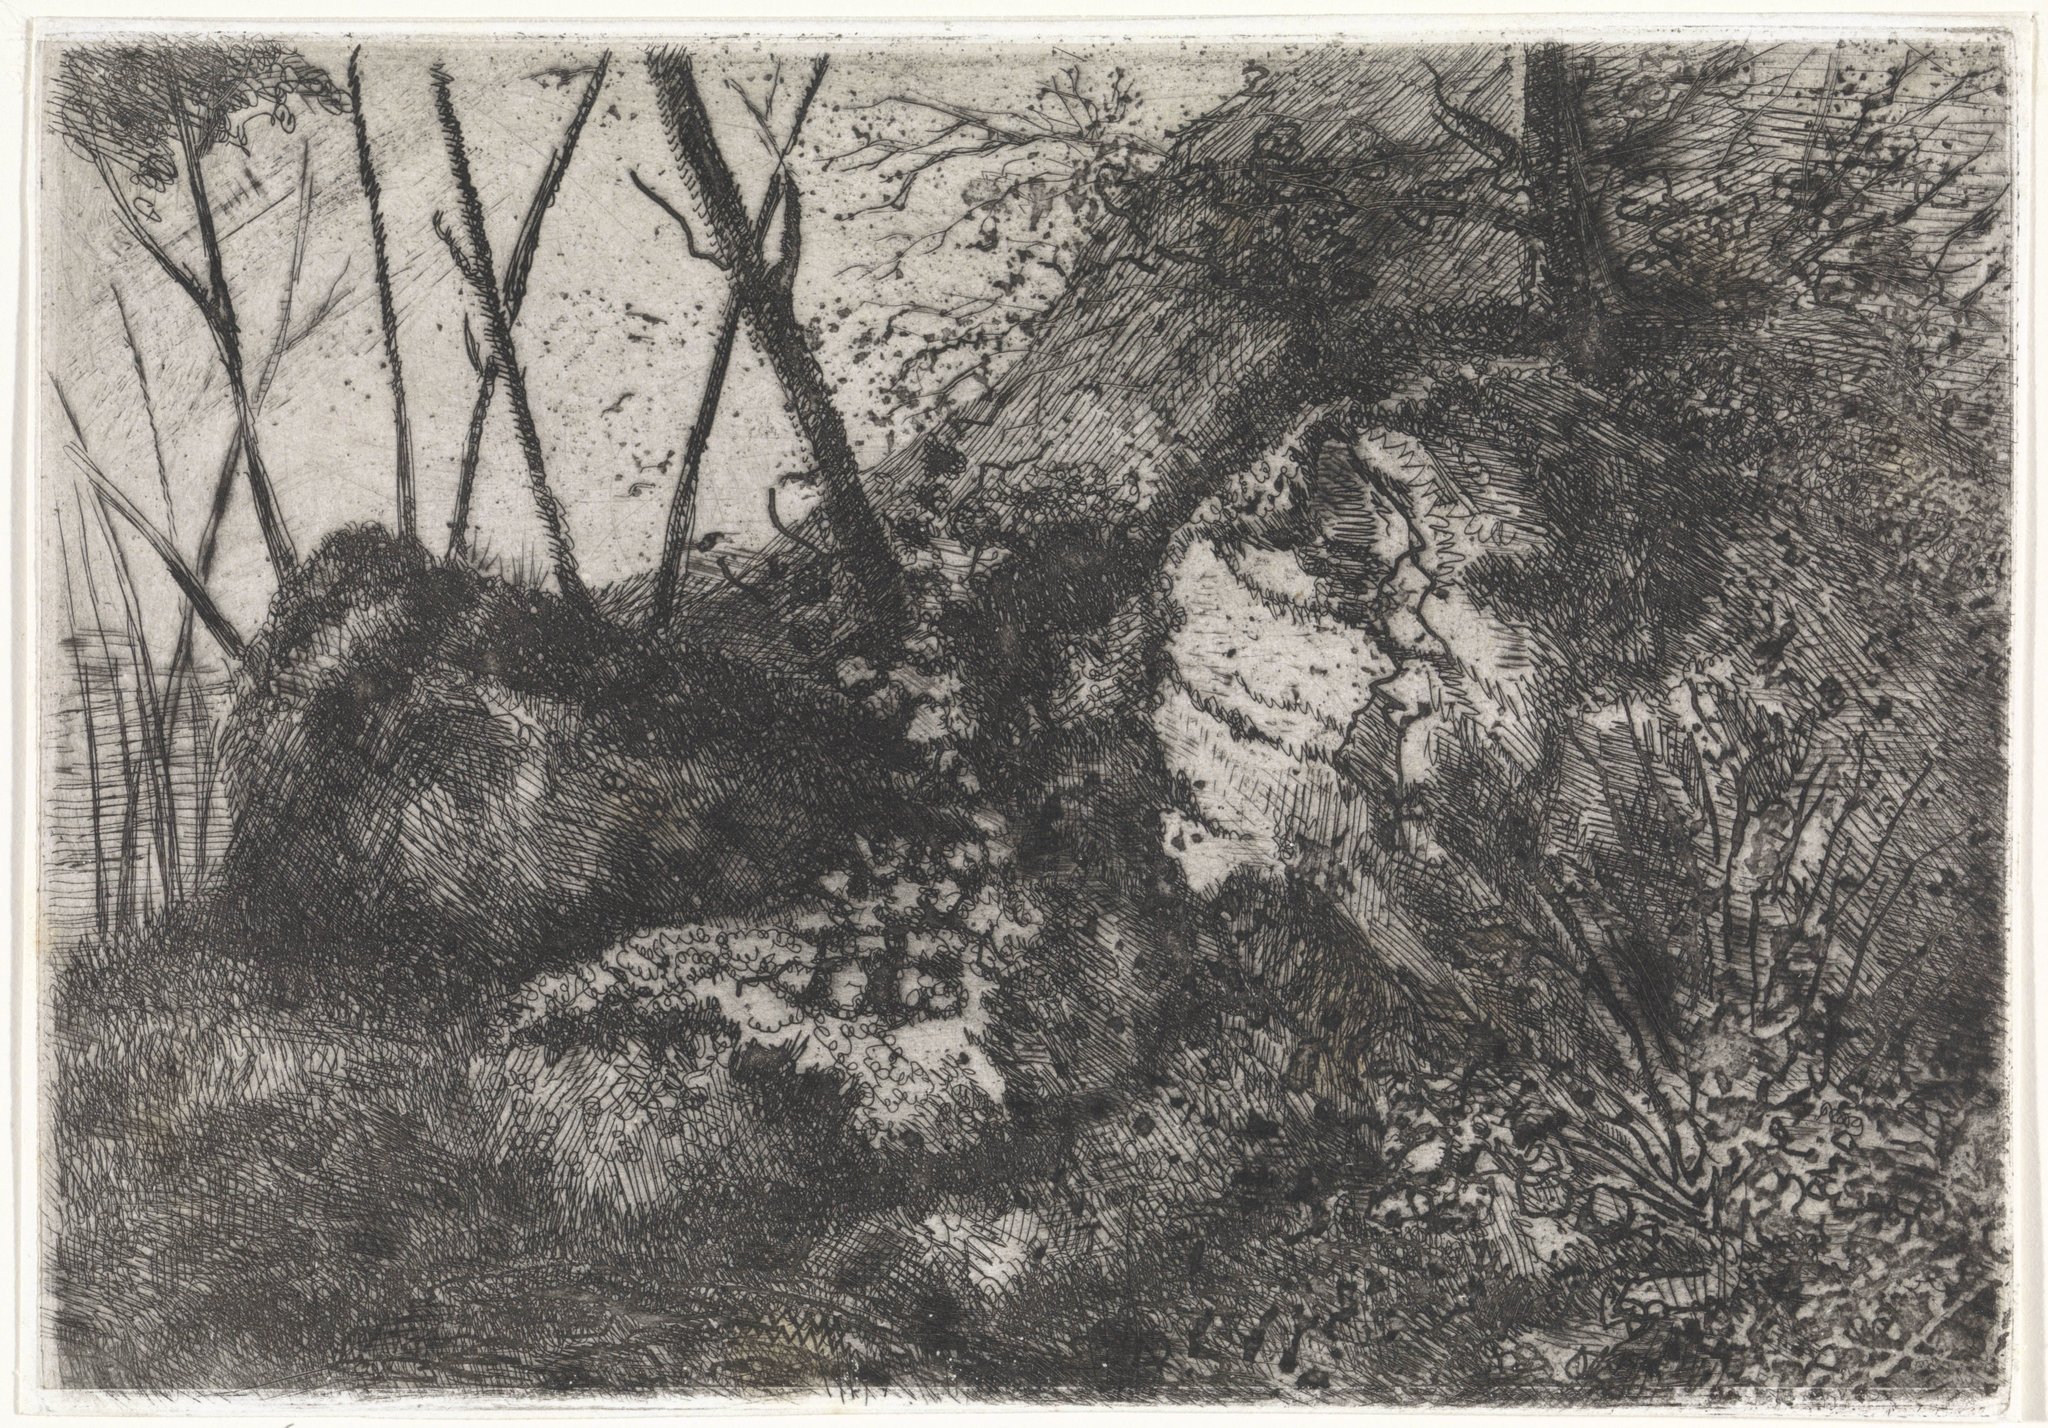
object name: print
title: Rotspartij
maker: arnoud schaepkens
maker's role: print maker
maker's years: 1816-1904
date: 1855-1904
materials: paper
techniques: drypoint, etching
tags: rocks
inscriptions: collector's mark: Lugt 2228